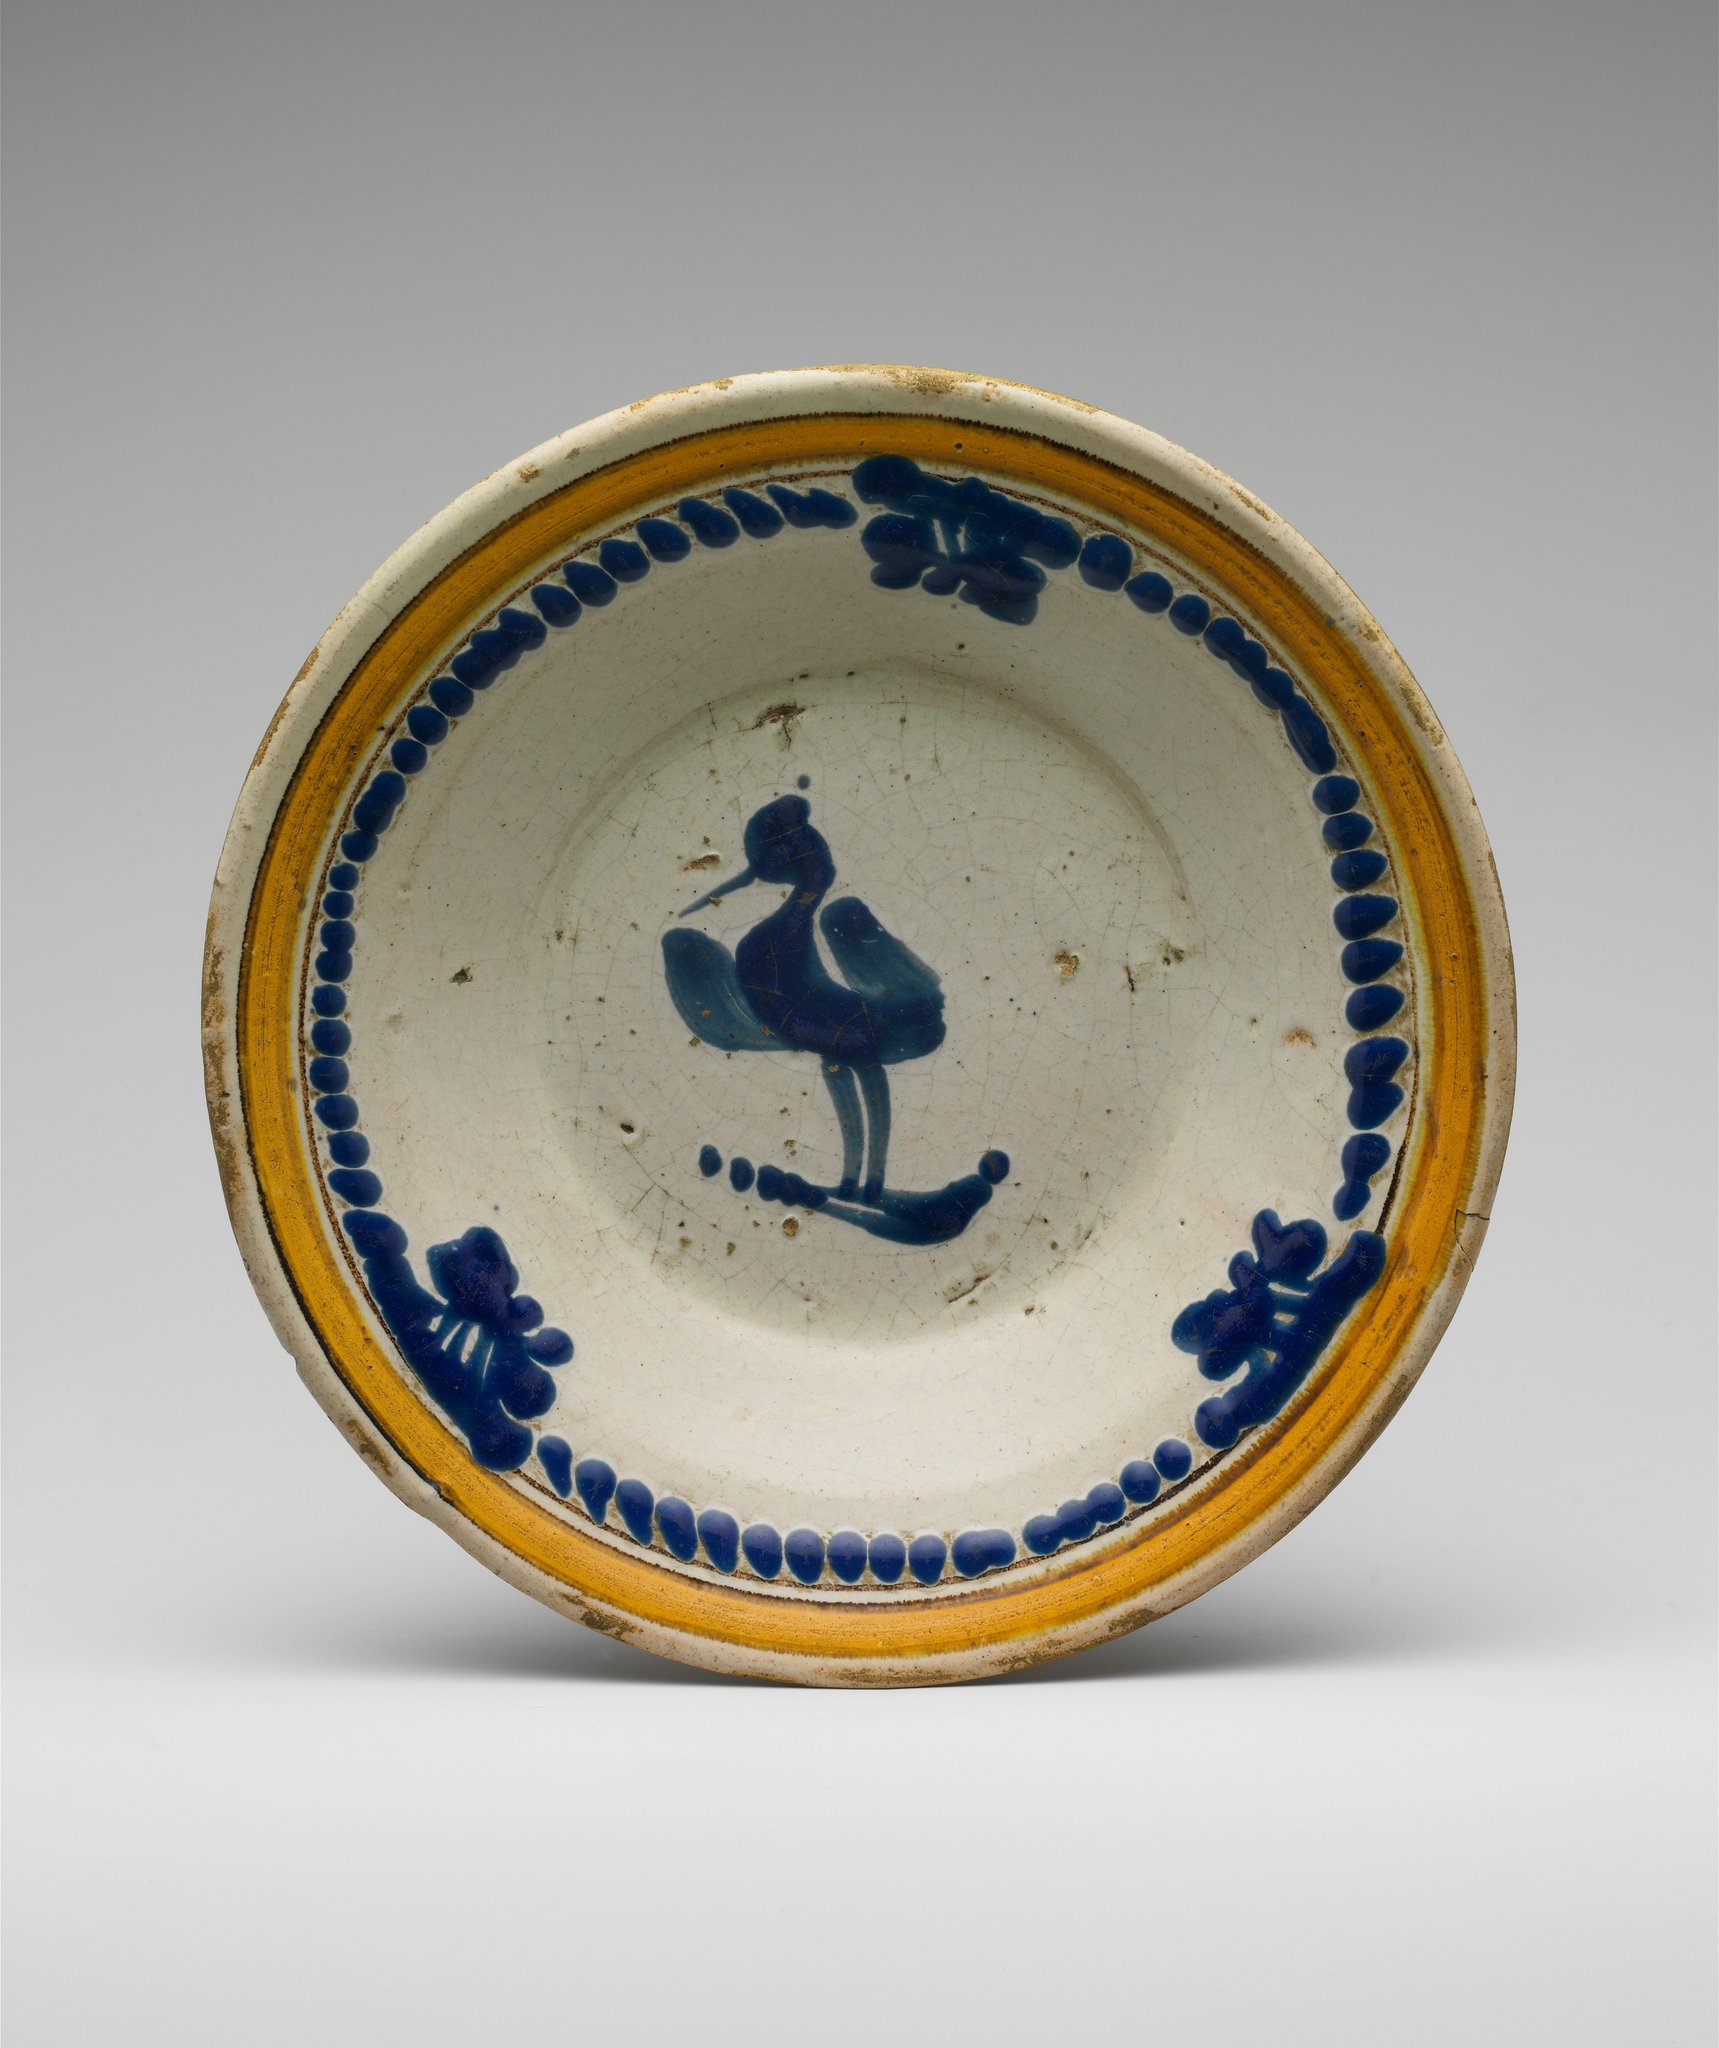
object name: plate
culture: mexican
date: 1800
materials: earthenware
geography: mexico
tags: birds